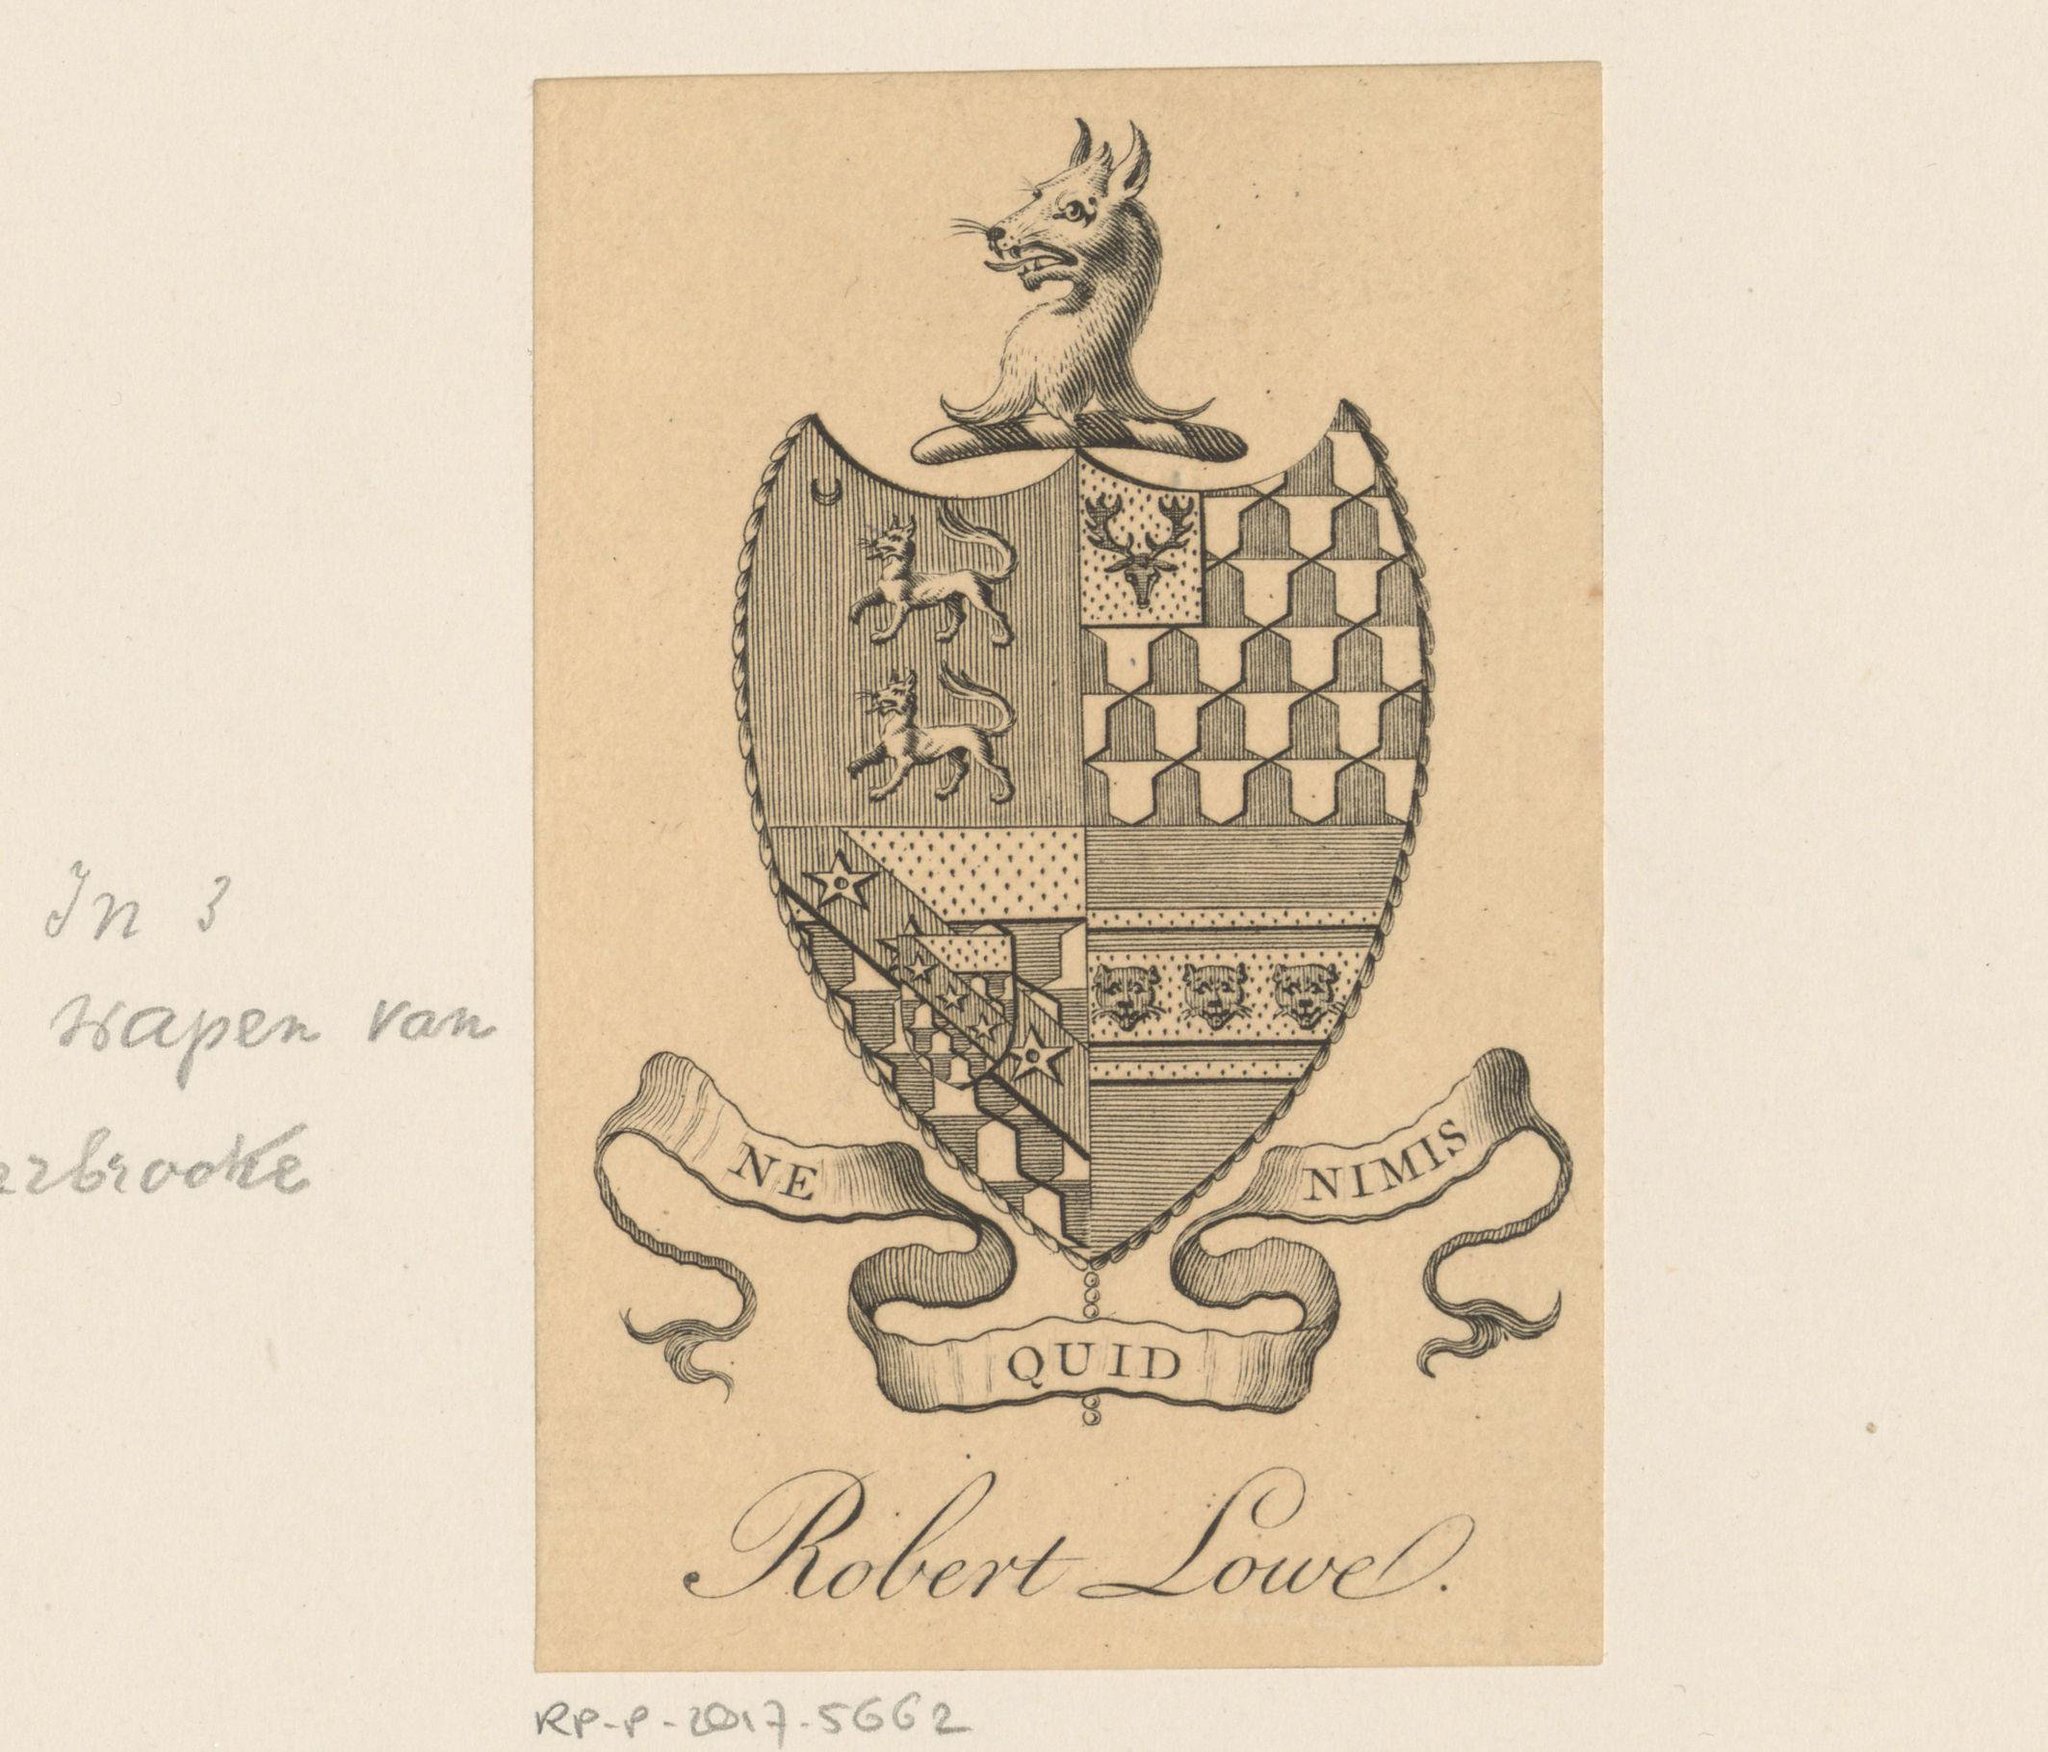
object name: bookplate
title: Ex libris van Robert Lowe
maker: Anonymous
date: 1800-1899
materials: paper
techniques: etching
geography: england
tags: armorial bearing, heraldry